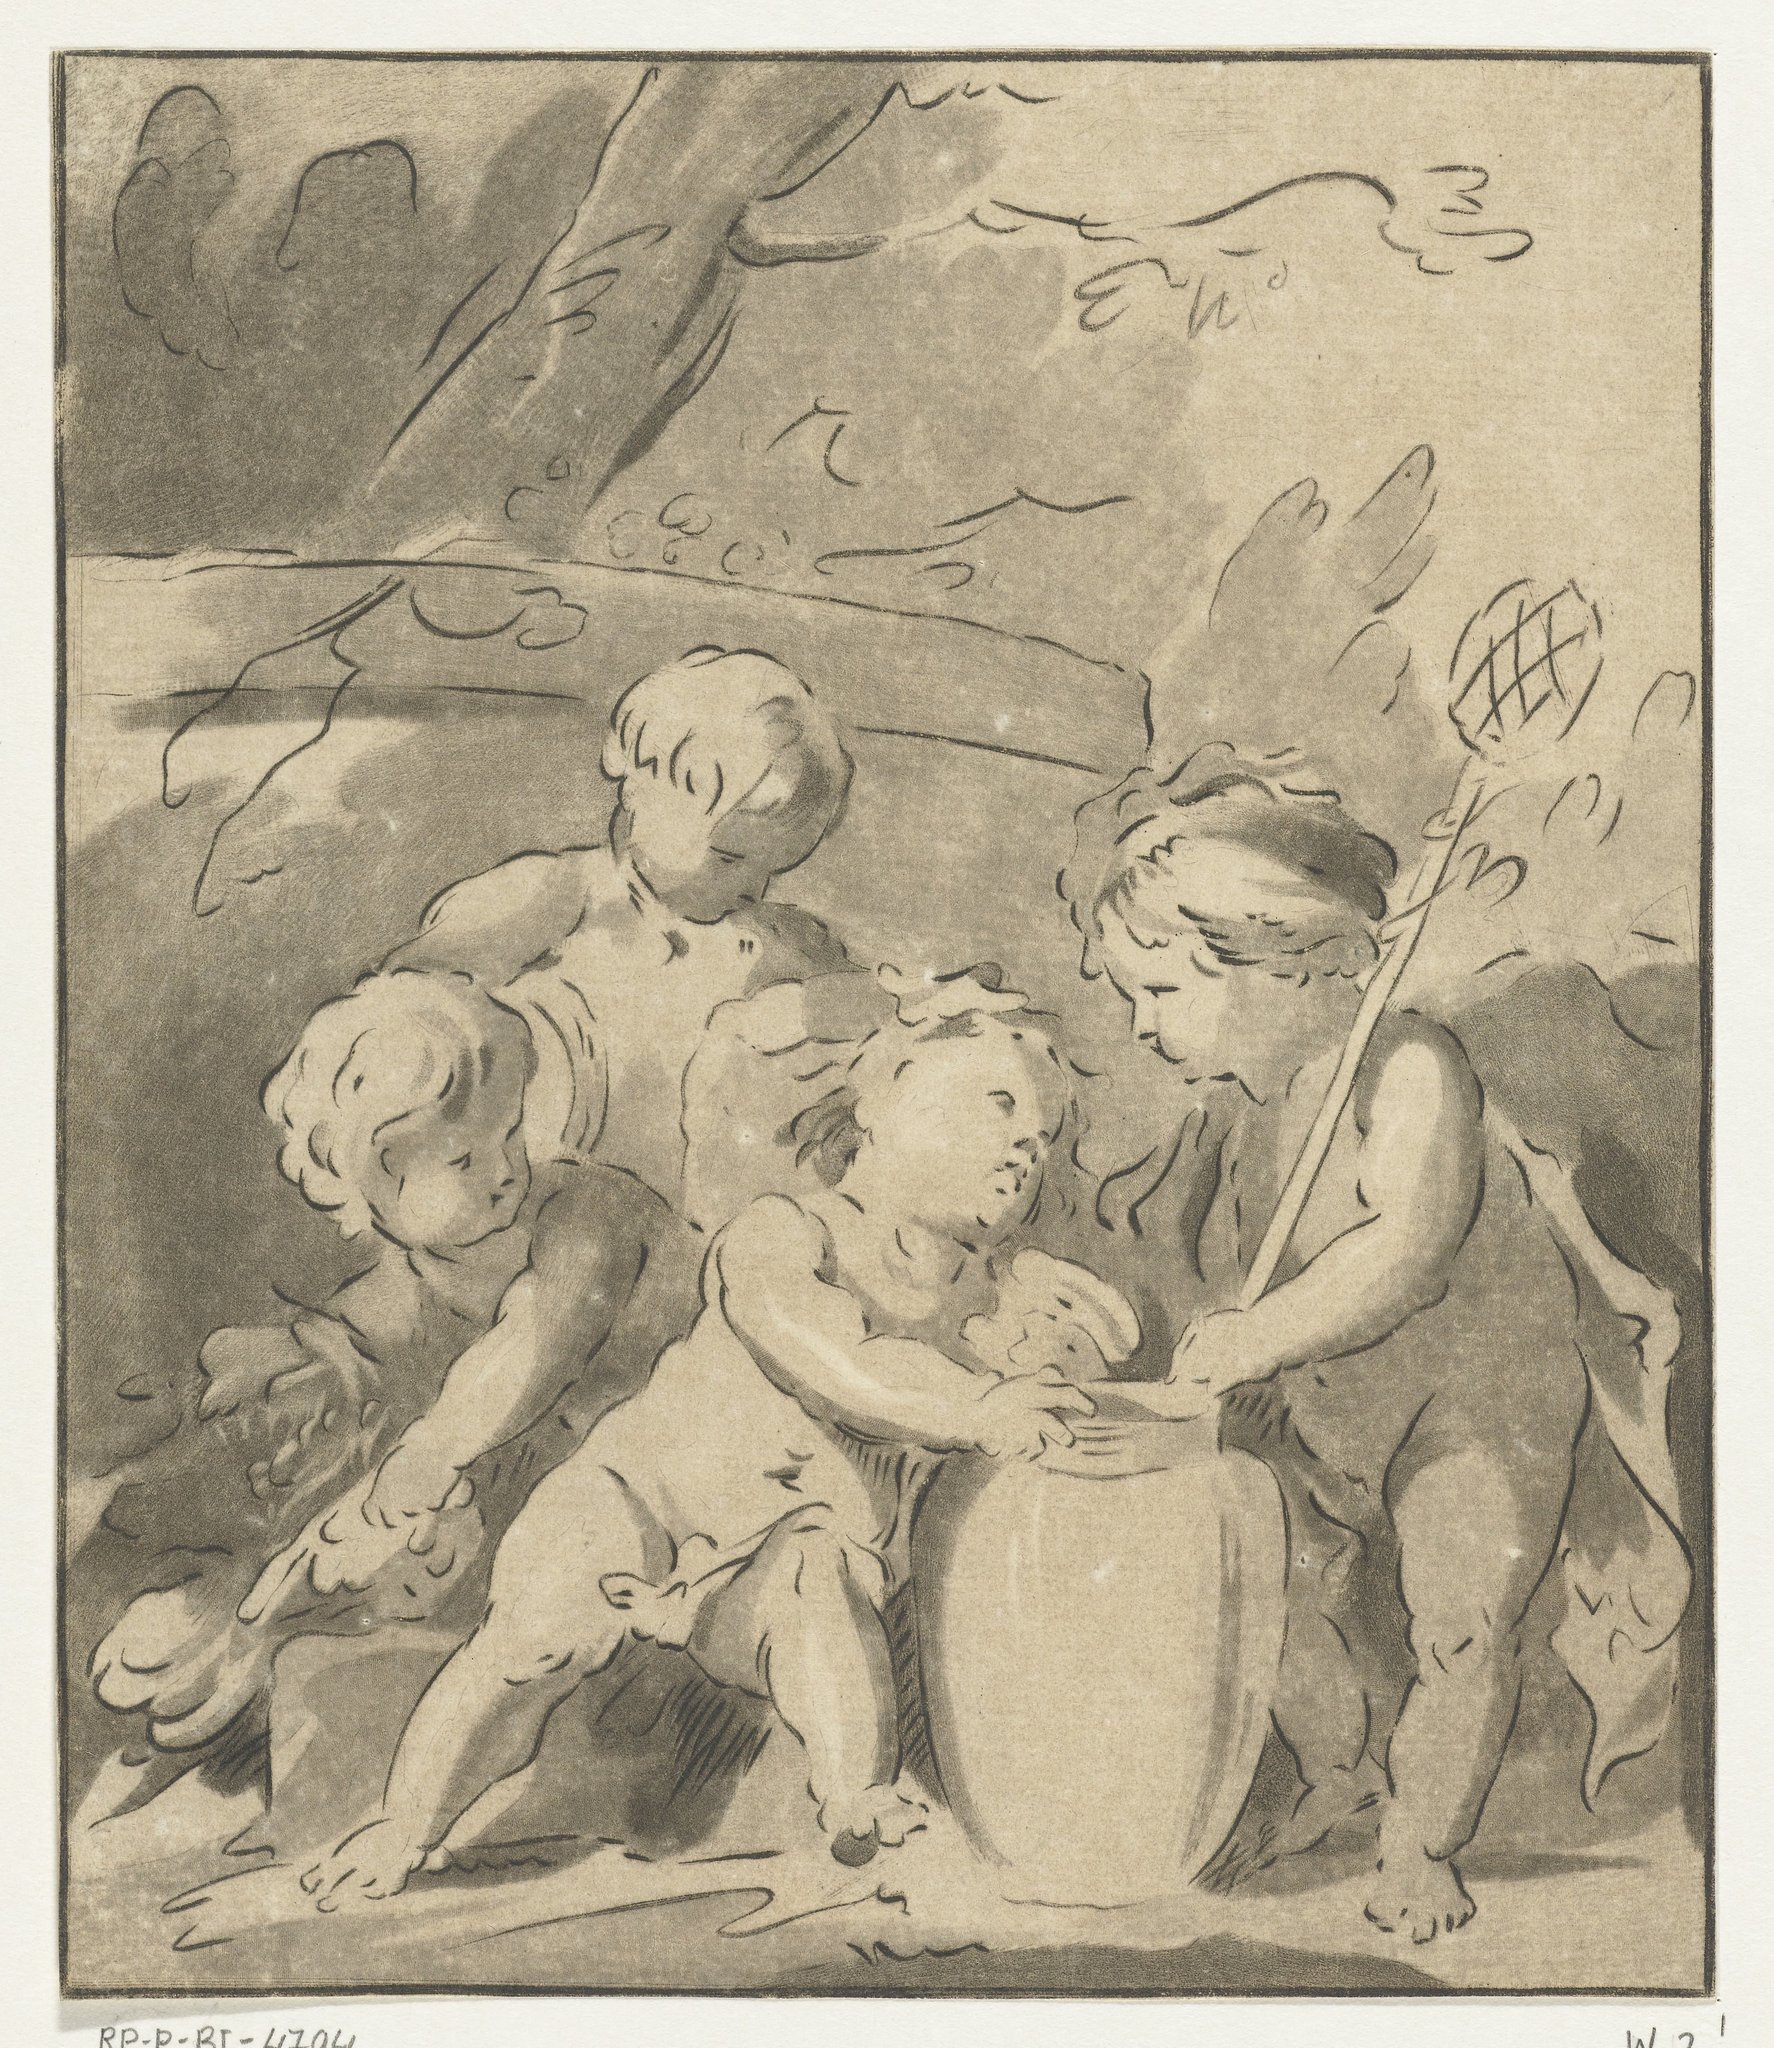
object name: print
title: Vier putti met vaas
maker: leendert brasser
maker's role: draughtsman, print maker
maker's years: 1727-1793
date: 1727-1793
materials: paper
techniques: aquatint, etching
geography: netherlands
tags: cupids: 'amores', 'amoretti', 'putti'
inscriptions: collector's mark: Lugt 2228